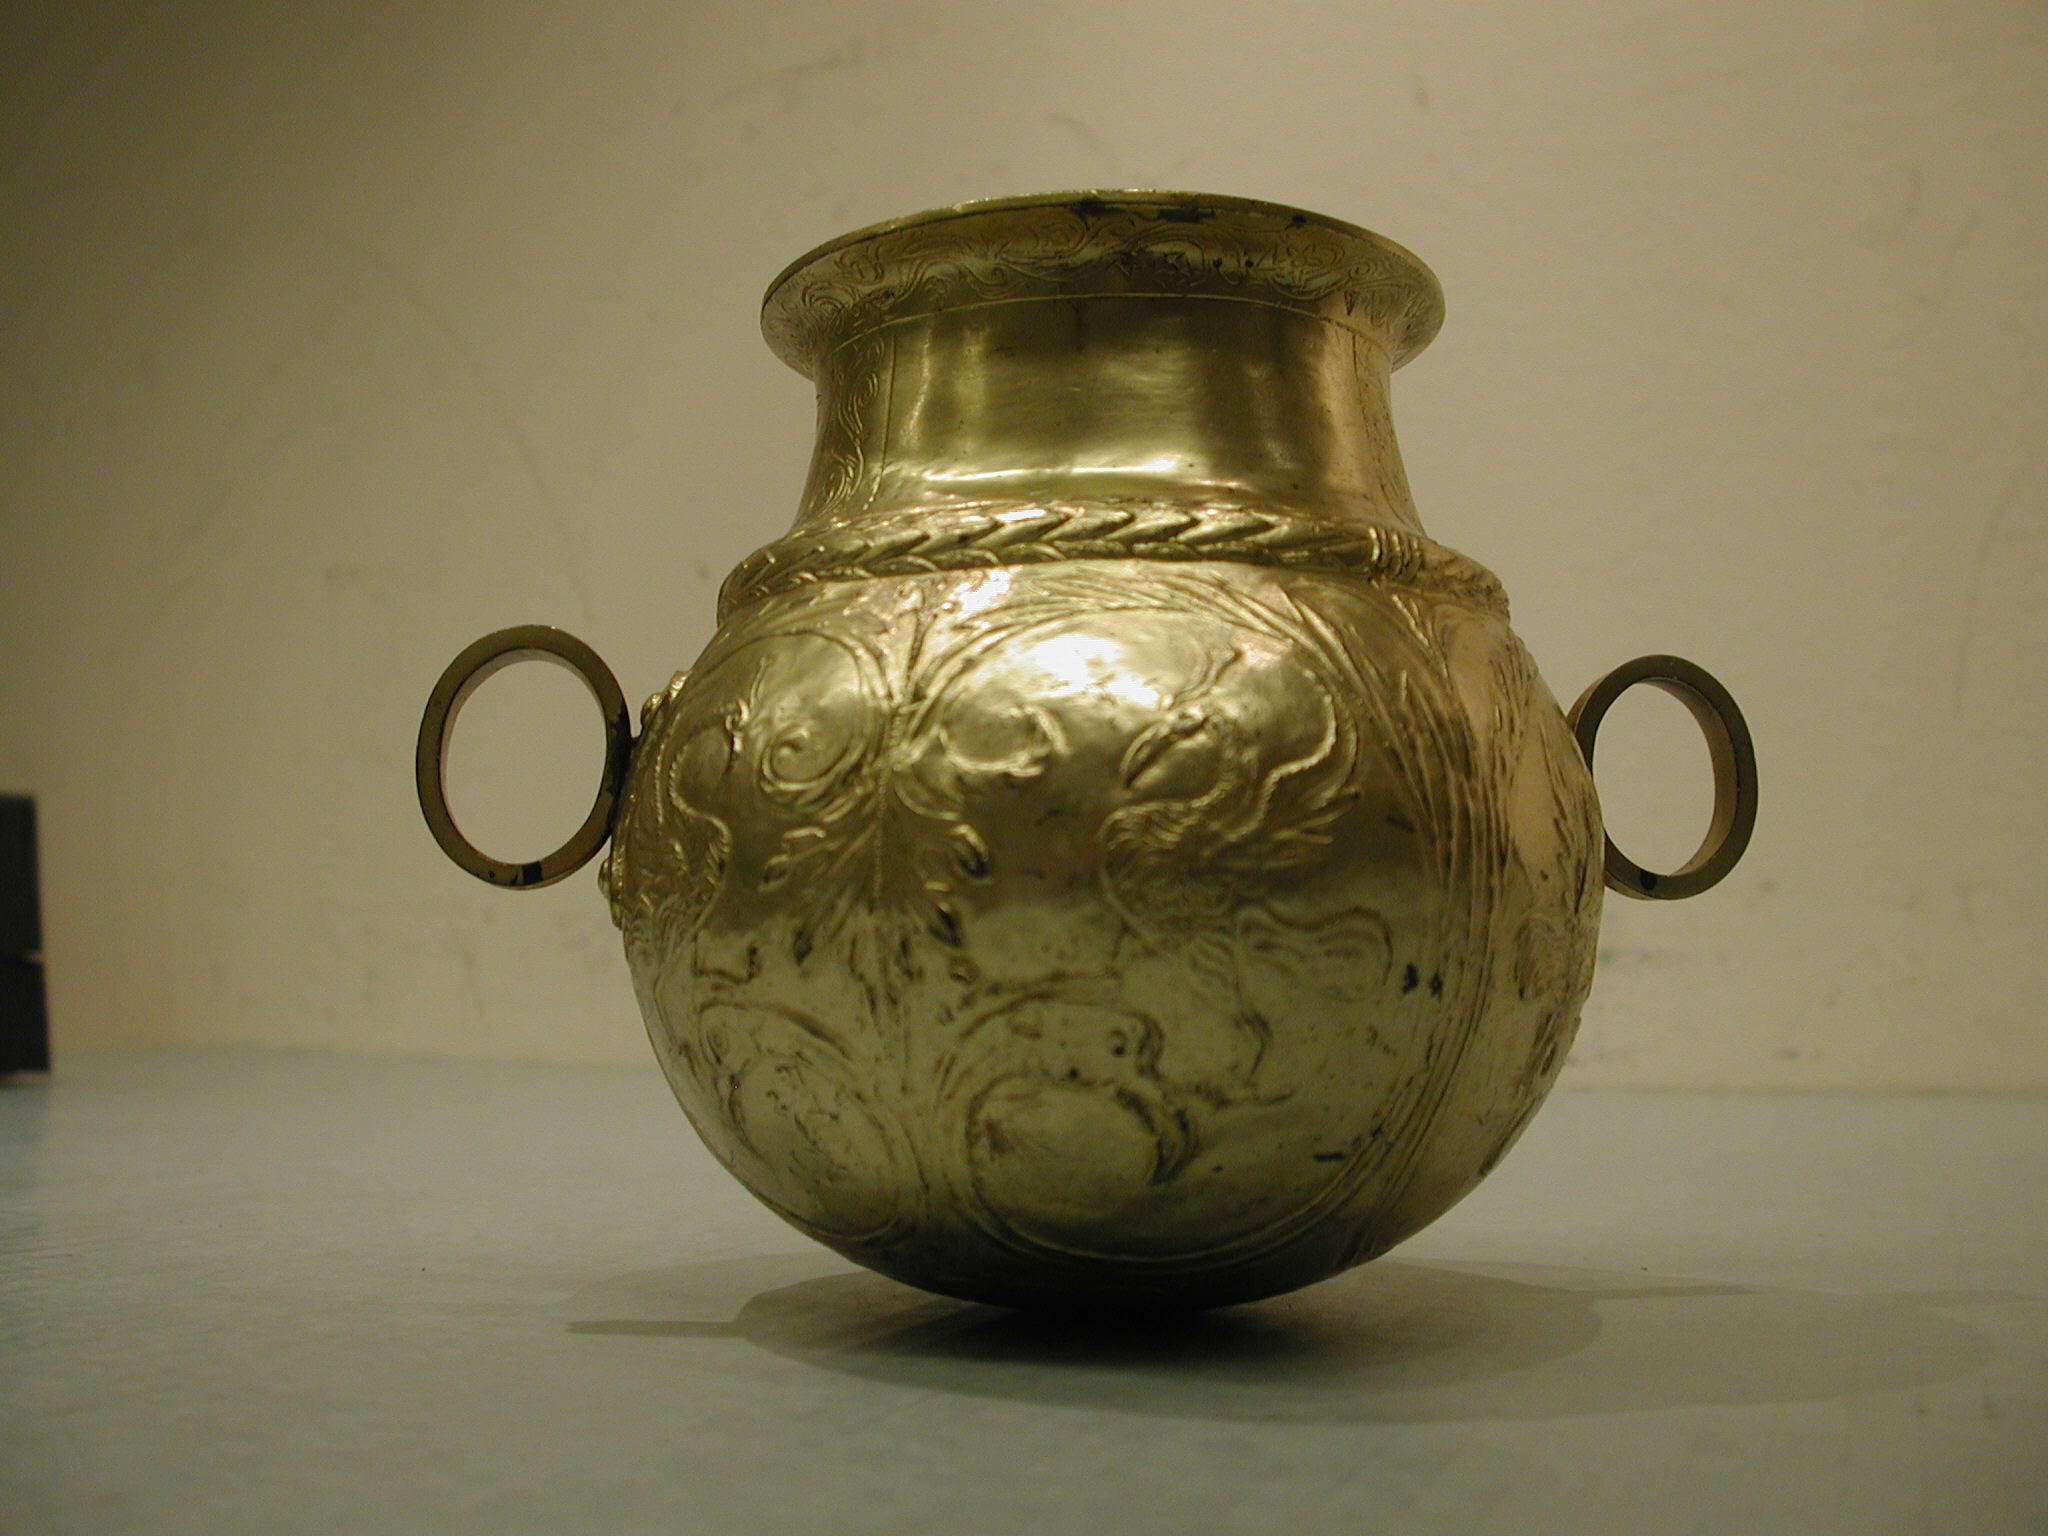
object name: vase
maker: elkington & co.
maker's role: manufacturer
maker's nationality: british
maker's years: 1829-1963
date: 1801-1900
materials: metal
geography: england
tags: birds,leaves,insignia